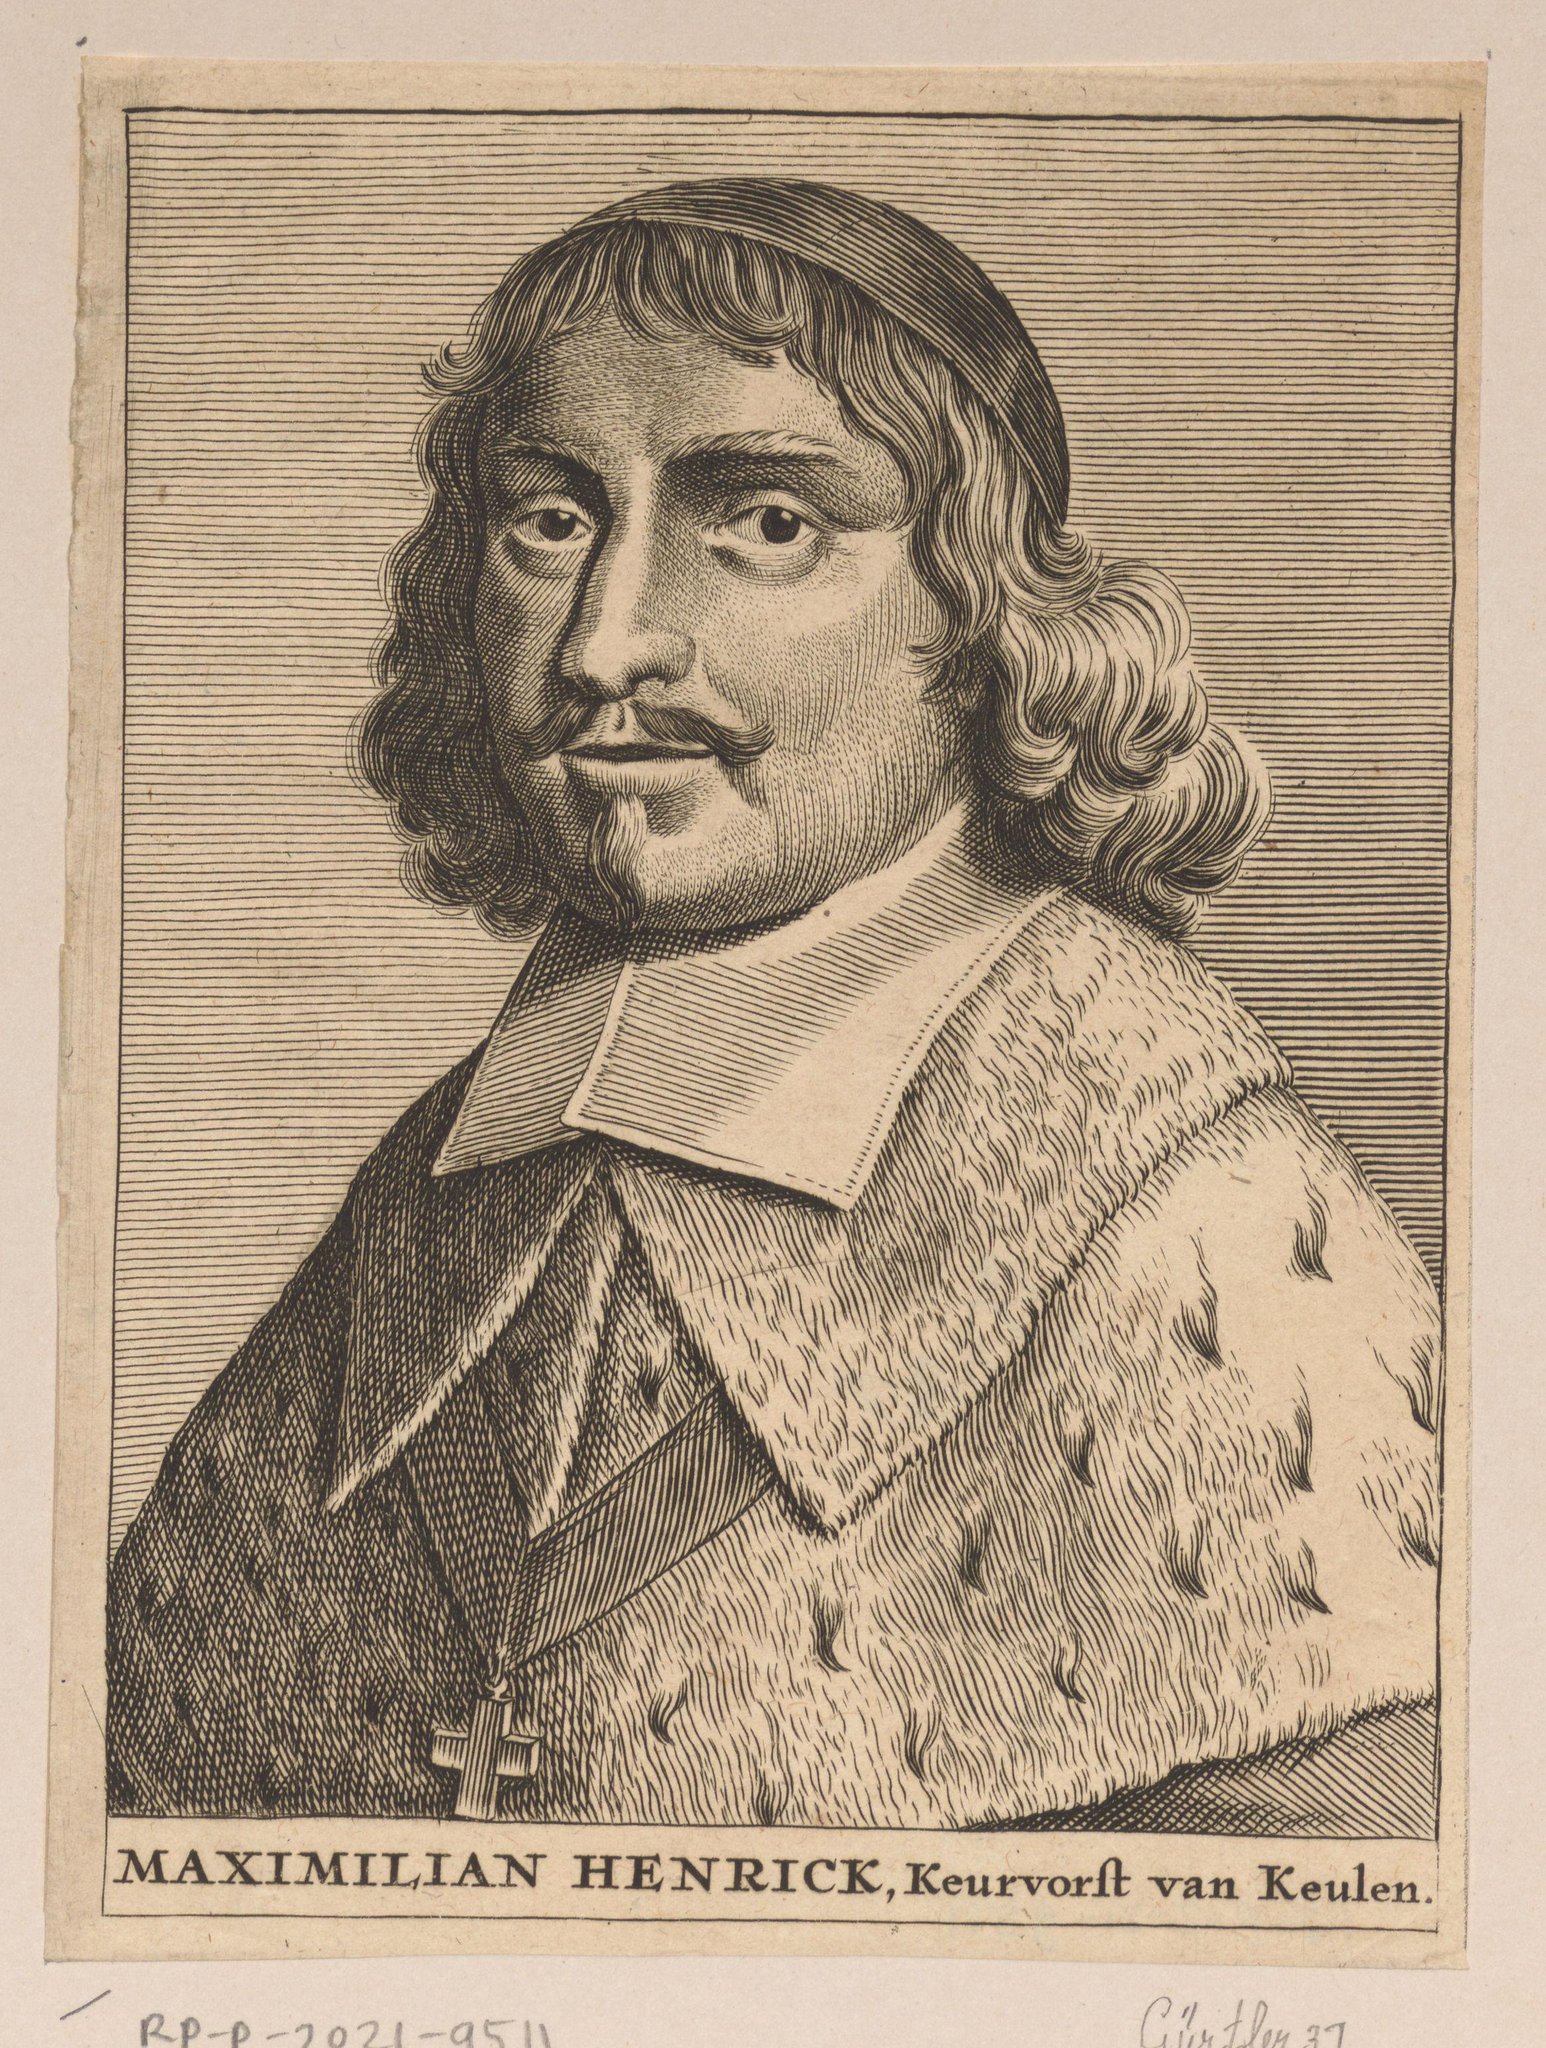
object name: print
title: Portret van Maximiliaan Hendrik van Beieren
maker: Anonymous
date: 1674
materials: paper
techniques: engraving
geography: northern netherlands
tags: maximiliaan hendrik van beieren, historical persons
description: Prent waarschijnlijk uit: Domselaer, Tobias van. Het ontroerde Nederlandt, door de wapenen des konings van Vrankryk (...). Amsterdam: Markus Willemsz. Doornik, 1674.